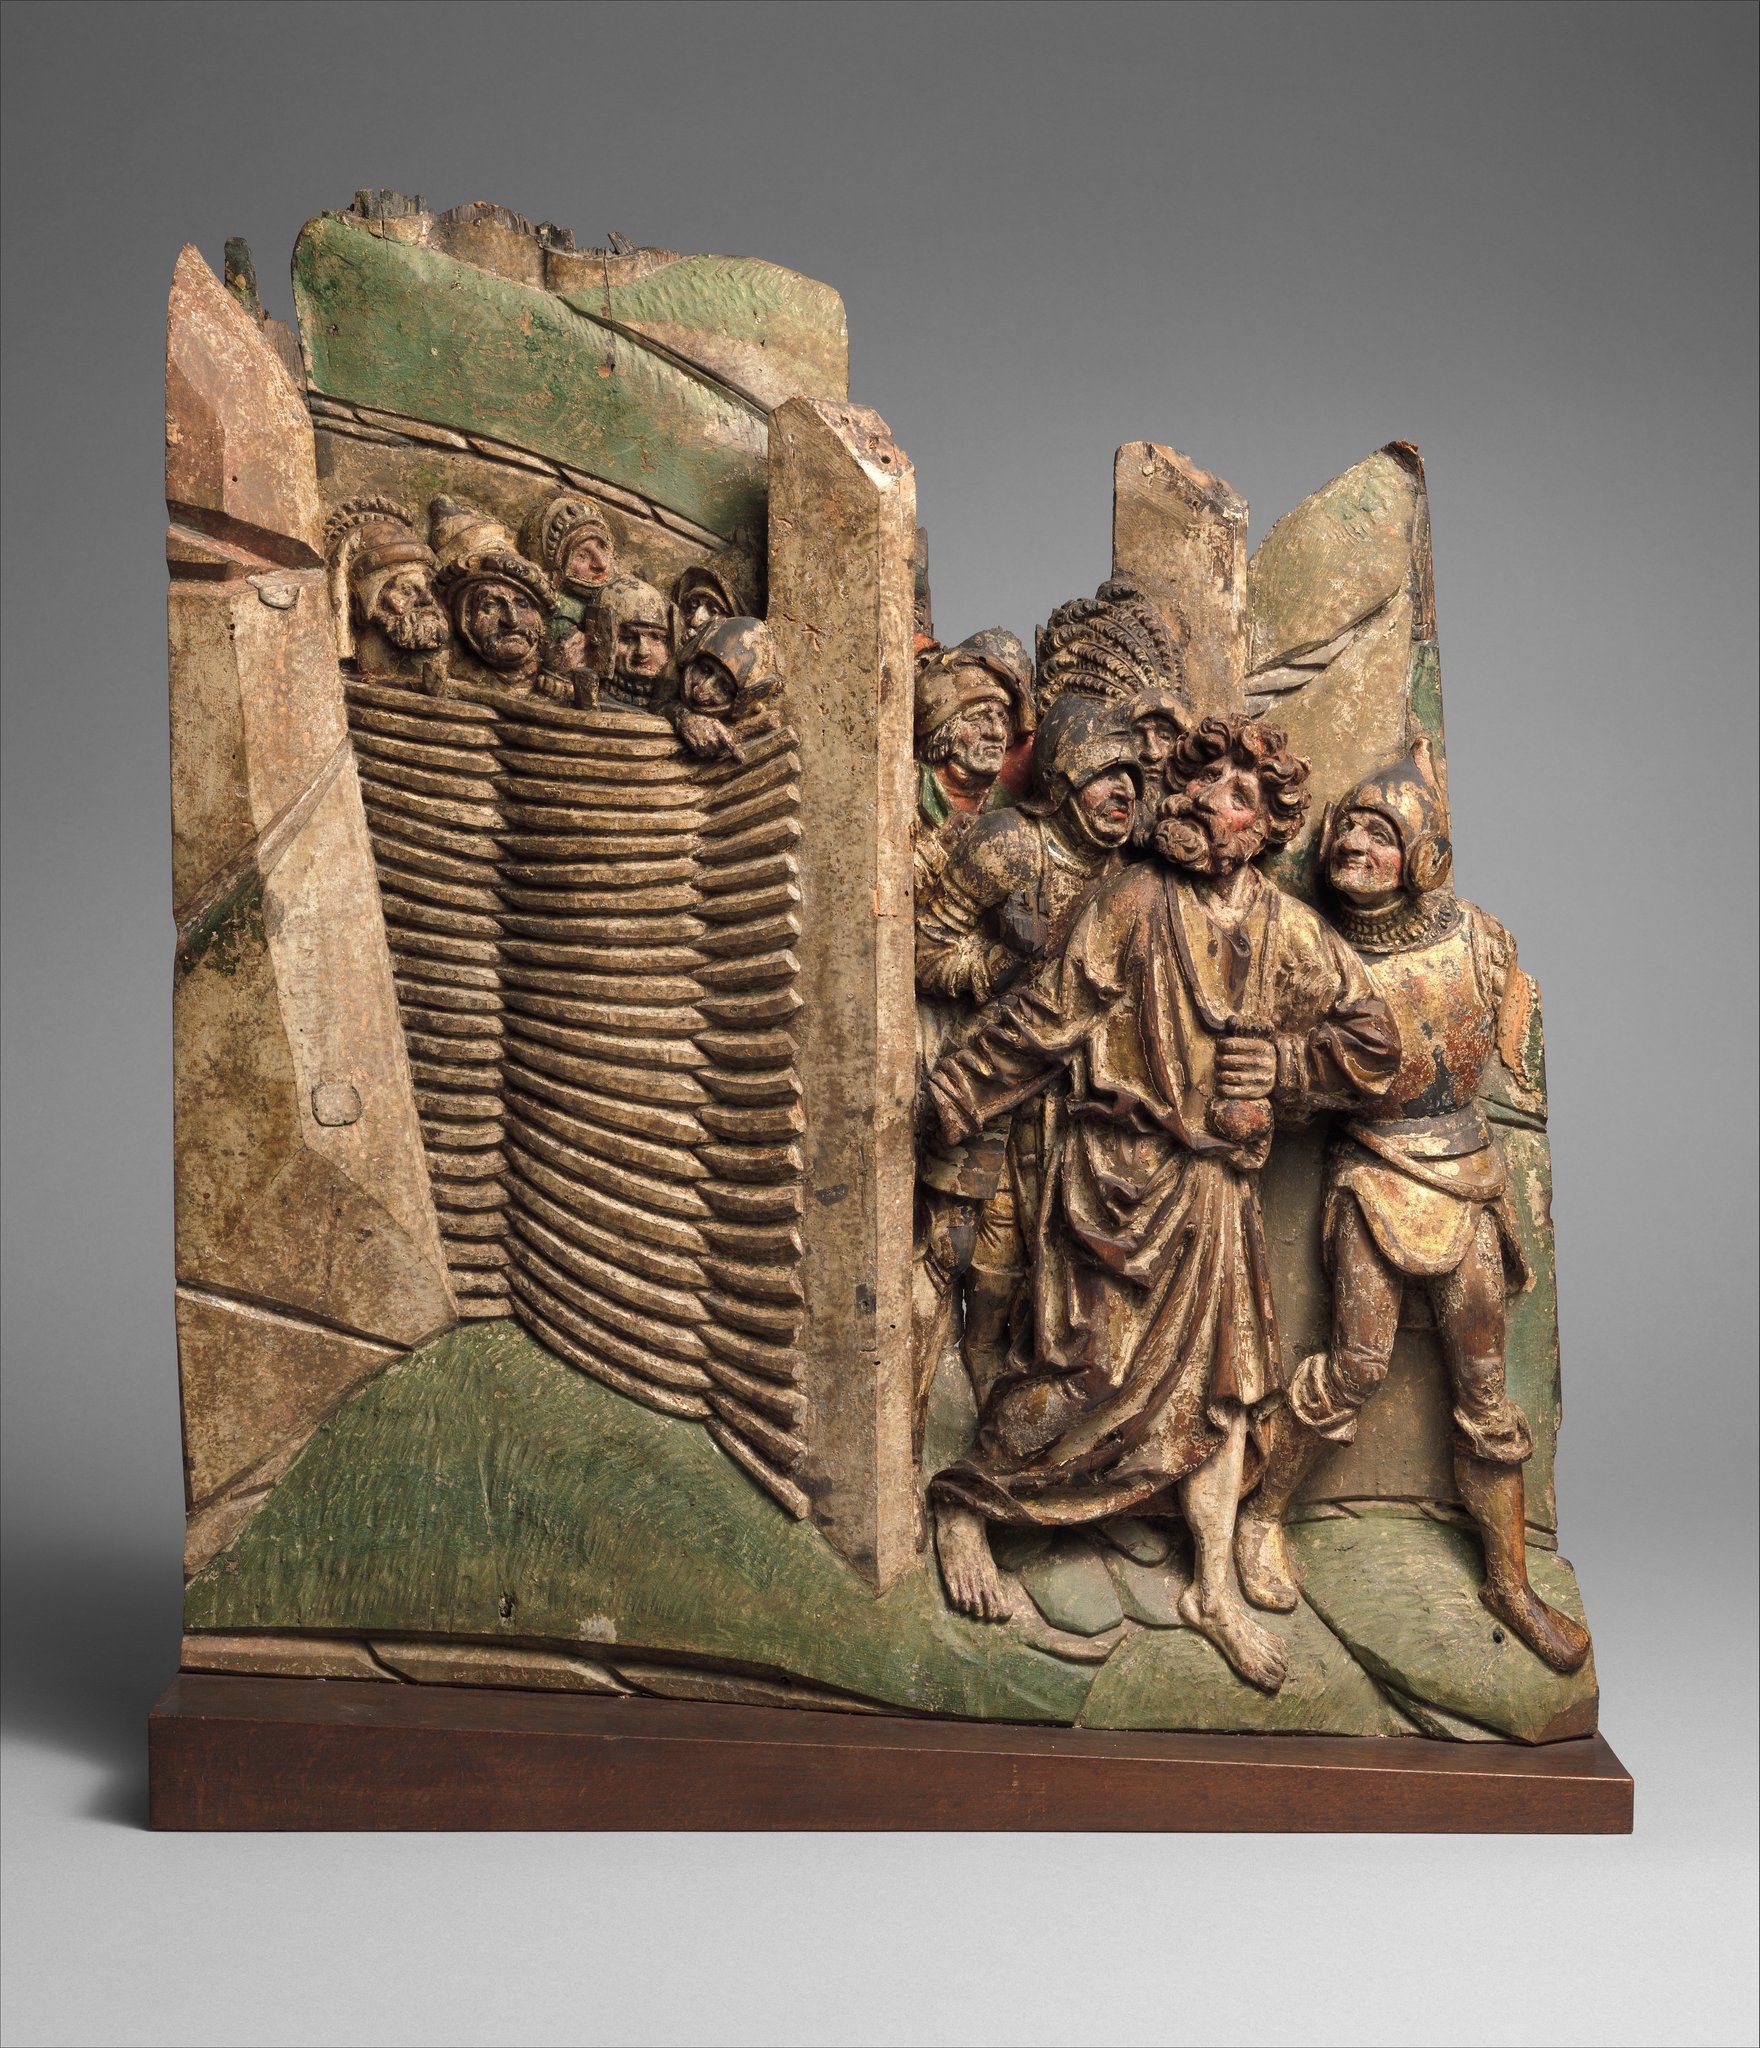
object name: relief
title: Judas Entering the Garden of Gethsemane to Betray Christ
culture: german or south netherlandish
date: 1401-1500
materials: paint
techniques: gilding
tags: soldiers,christ